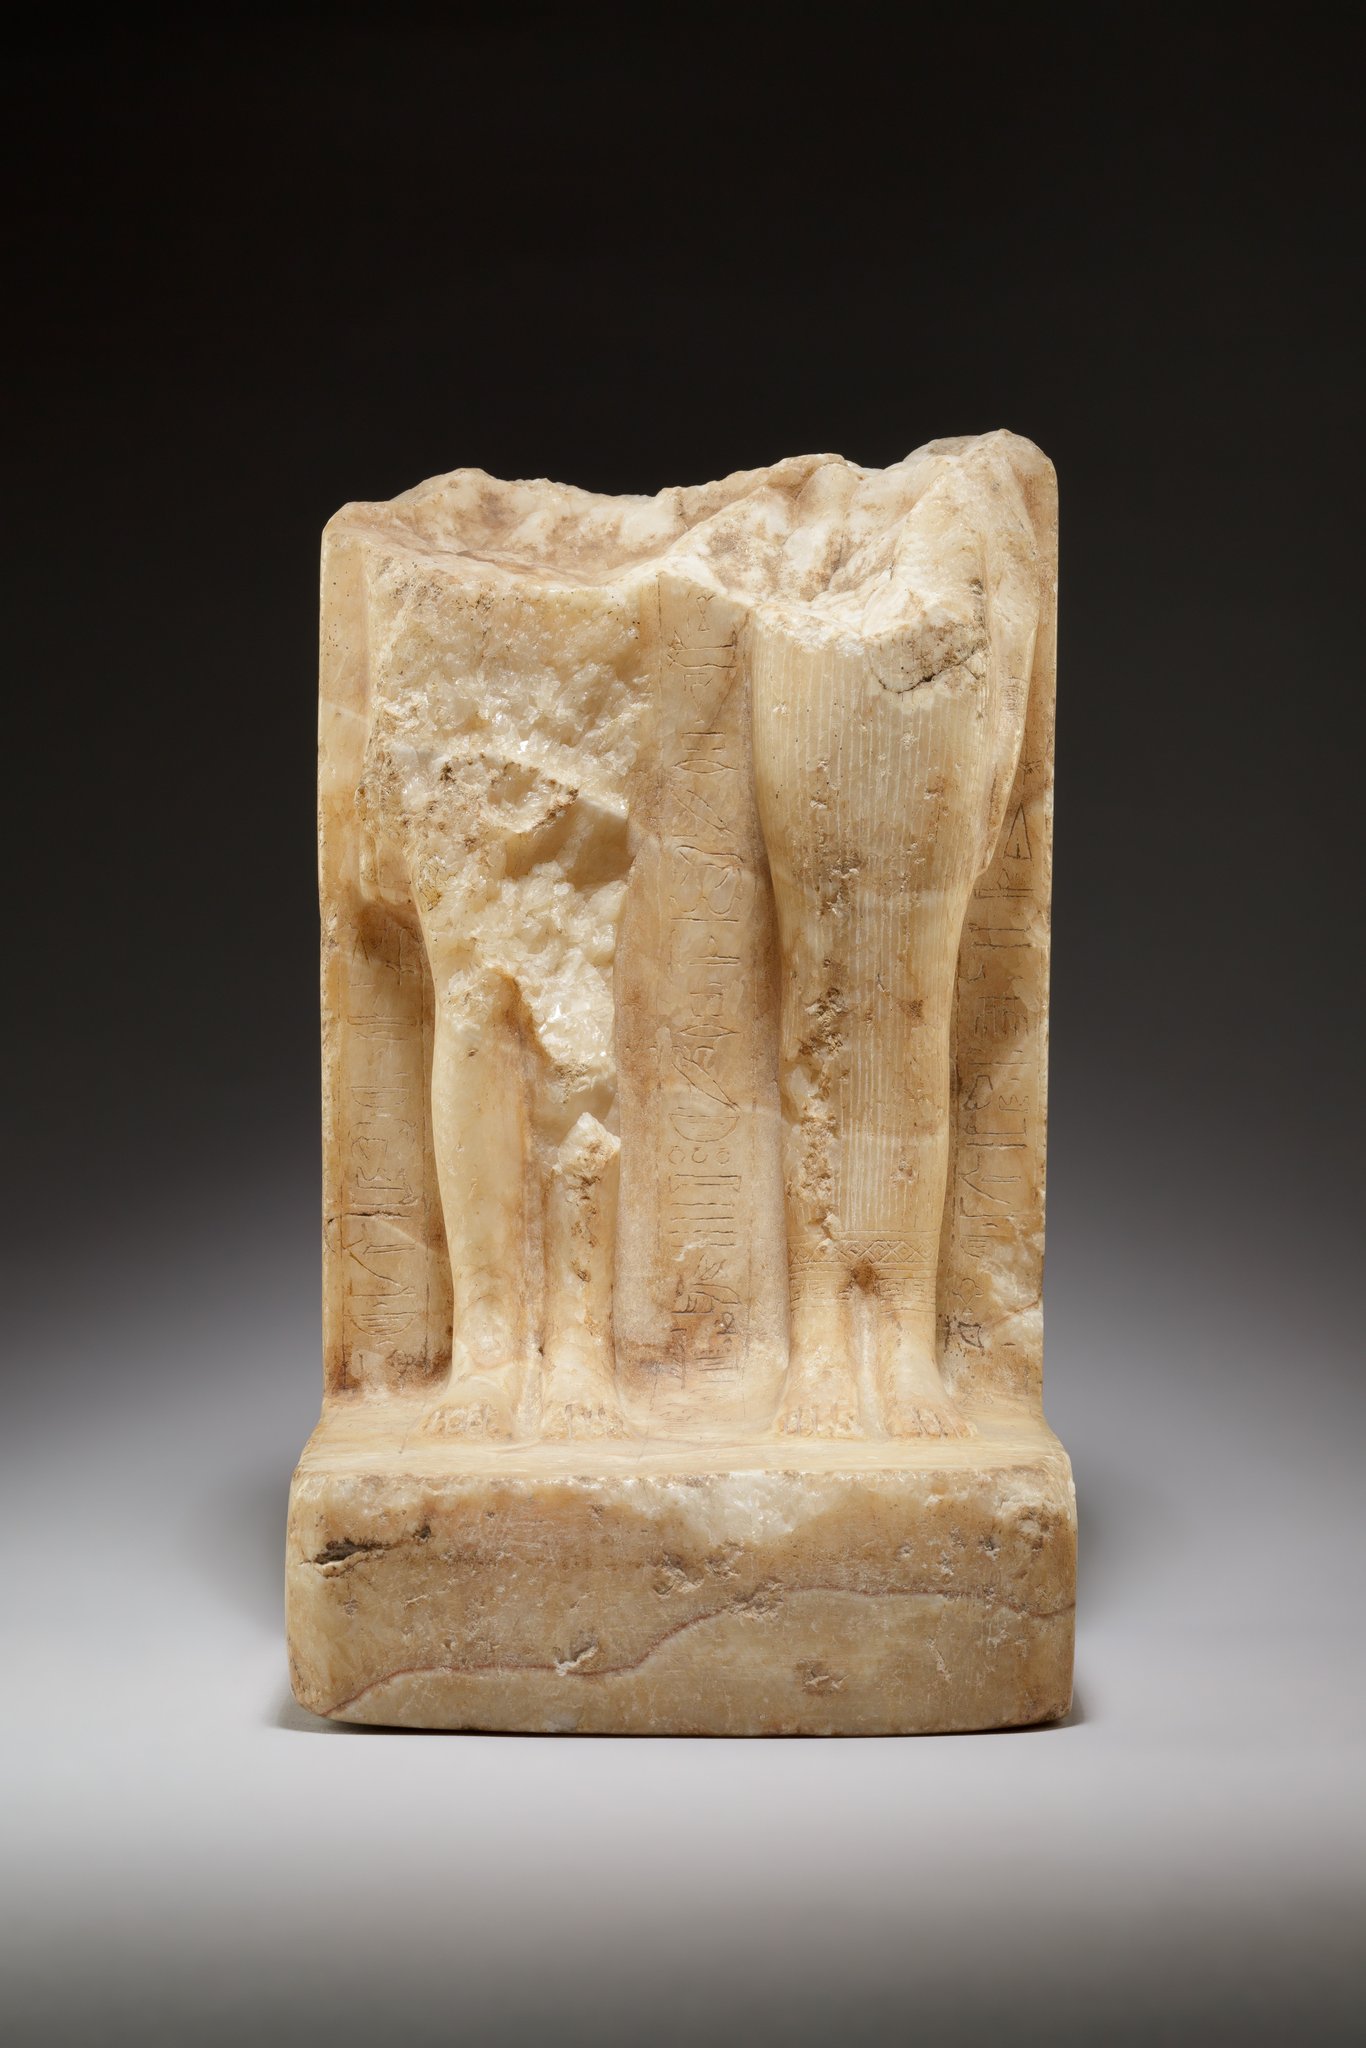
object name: statue, pair, amenemhat, ahmose baketamun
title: Pair Statue of Amenemhat and Ahmose-Baketamun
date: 1478-1425 BCE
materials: stone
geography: southern upper egypt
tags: hieroglyphs